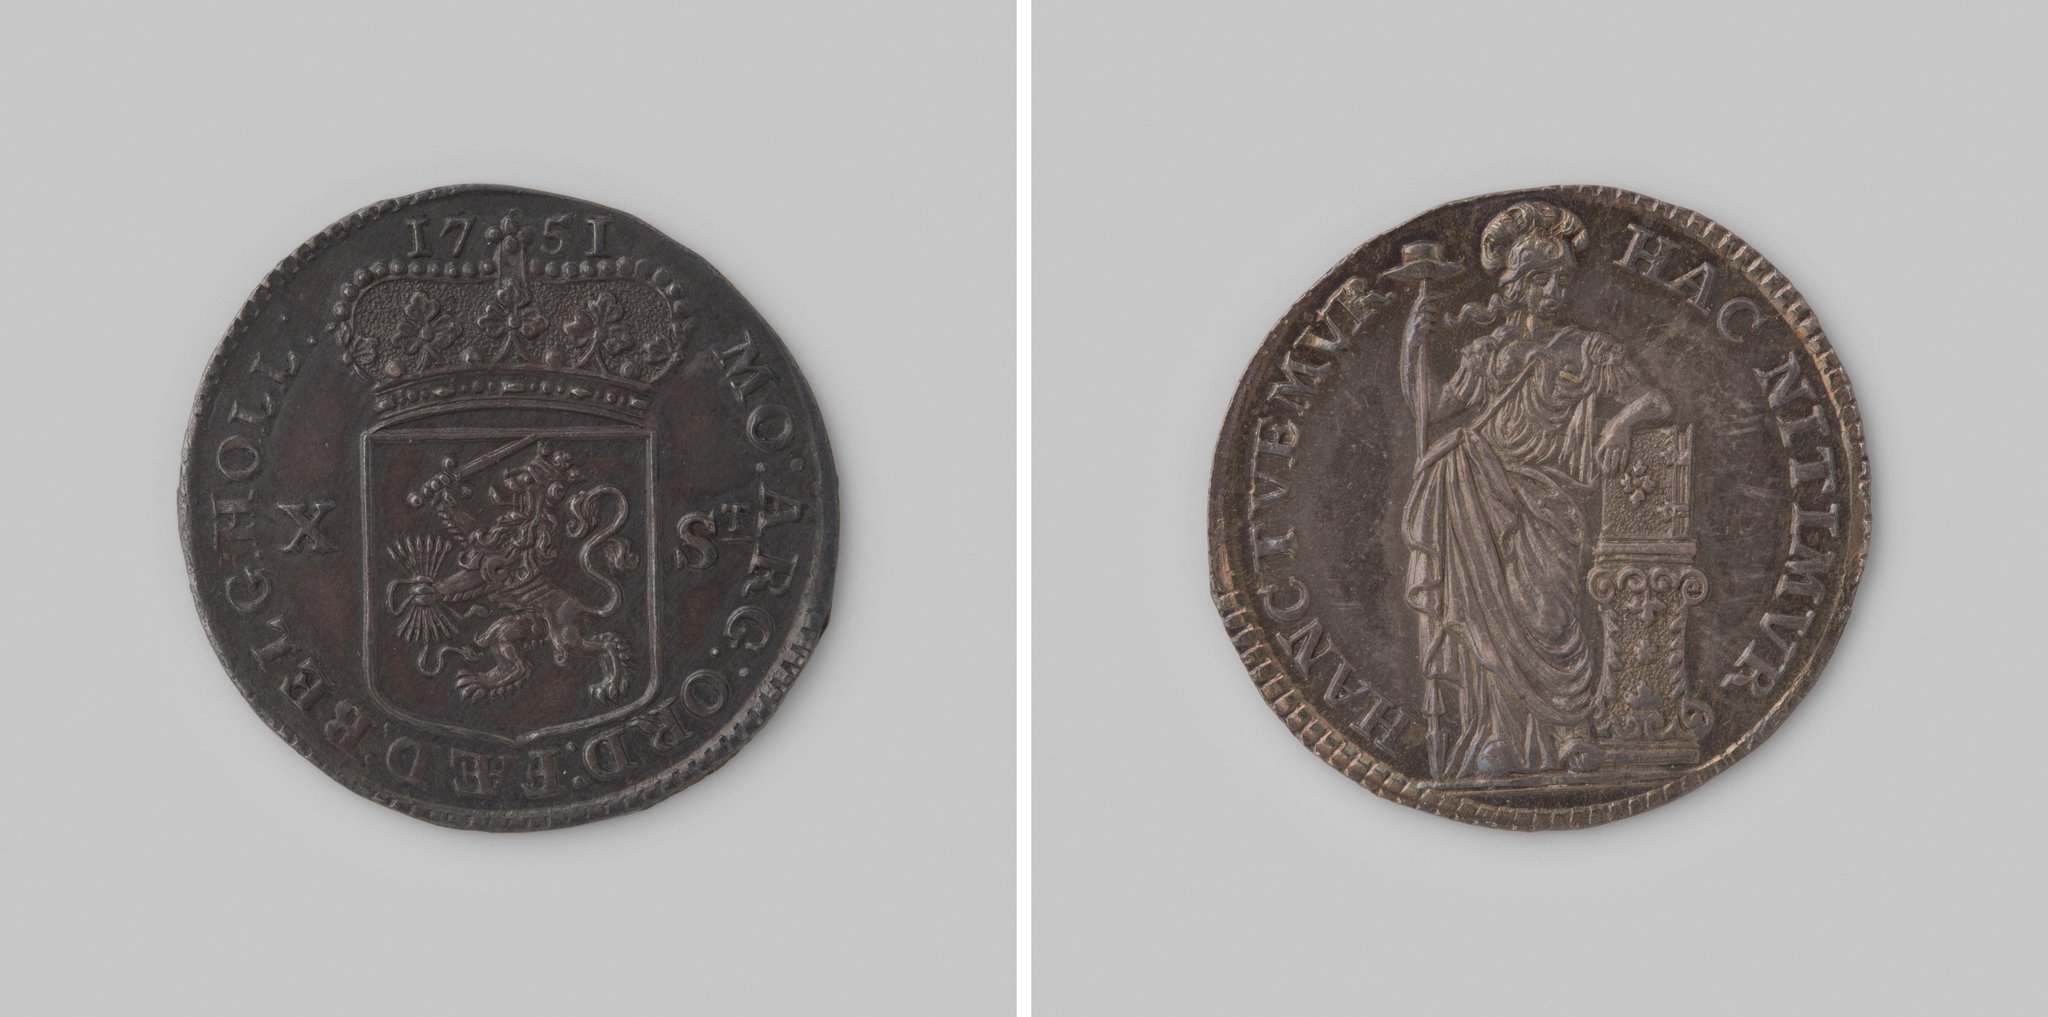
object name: coin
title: Holland, halve gulden, 1751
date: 1751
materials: silver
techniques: striking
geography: dordrecht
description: Zilveren munt. Voorzijde: tussen waarde-aanduiding X St gekroond generaliteitswapenschild. Jaartal boven kroon. Keerzijde: staande Nederlandse maagd met in rechterhand speer, waarop hoed en met linkerhand steunend op altaar, waarop bijbel. Zonder kabelrand